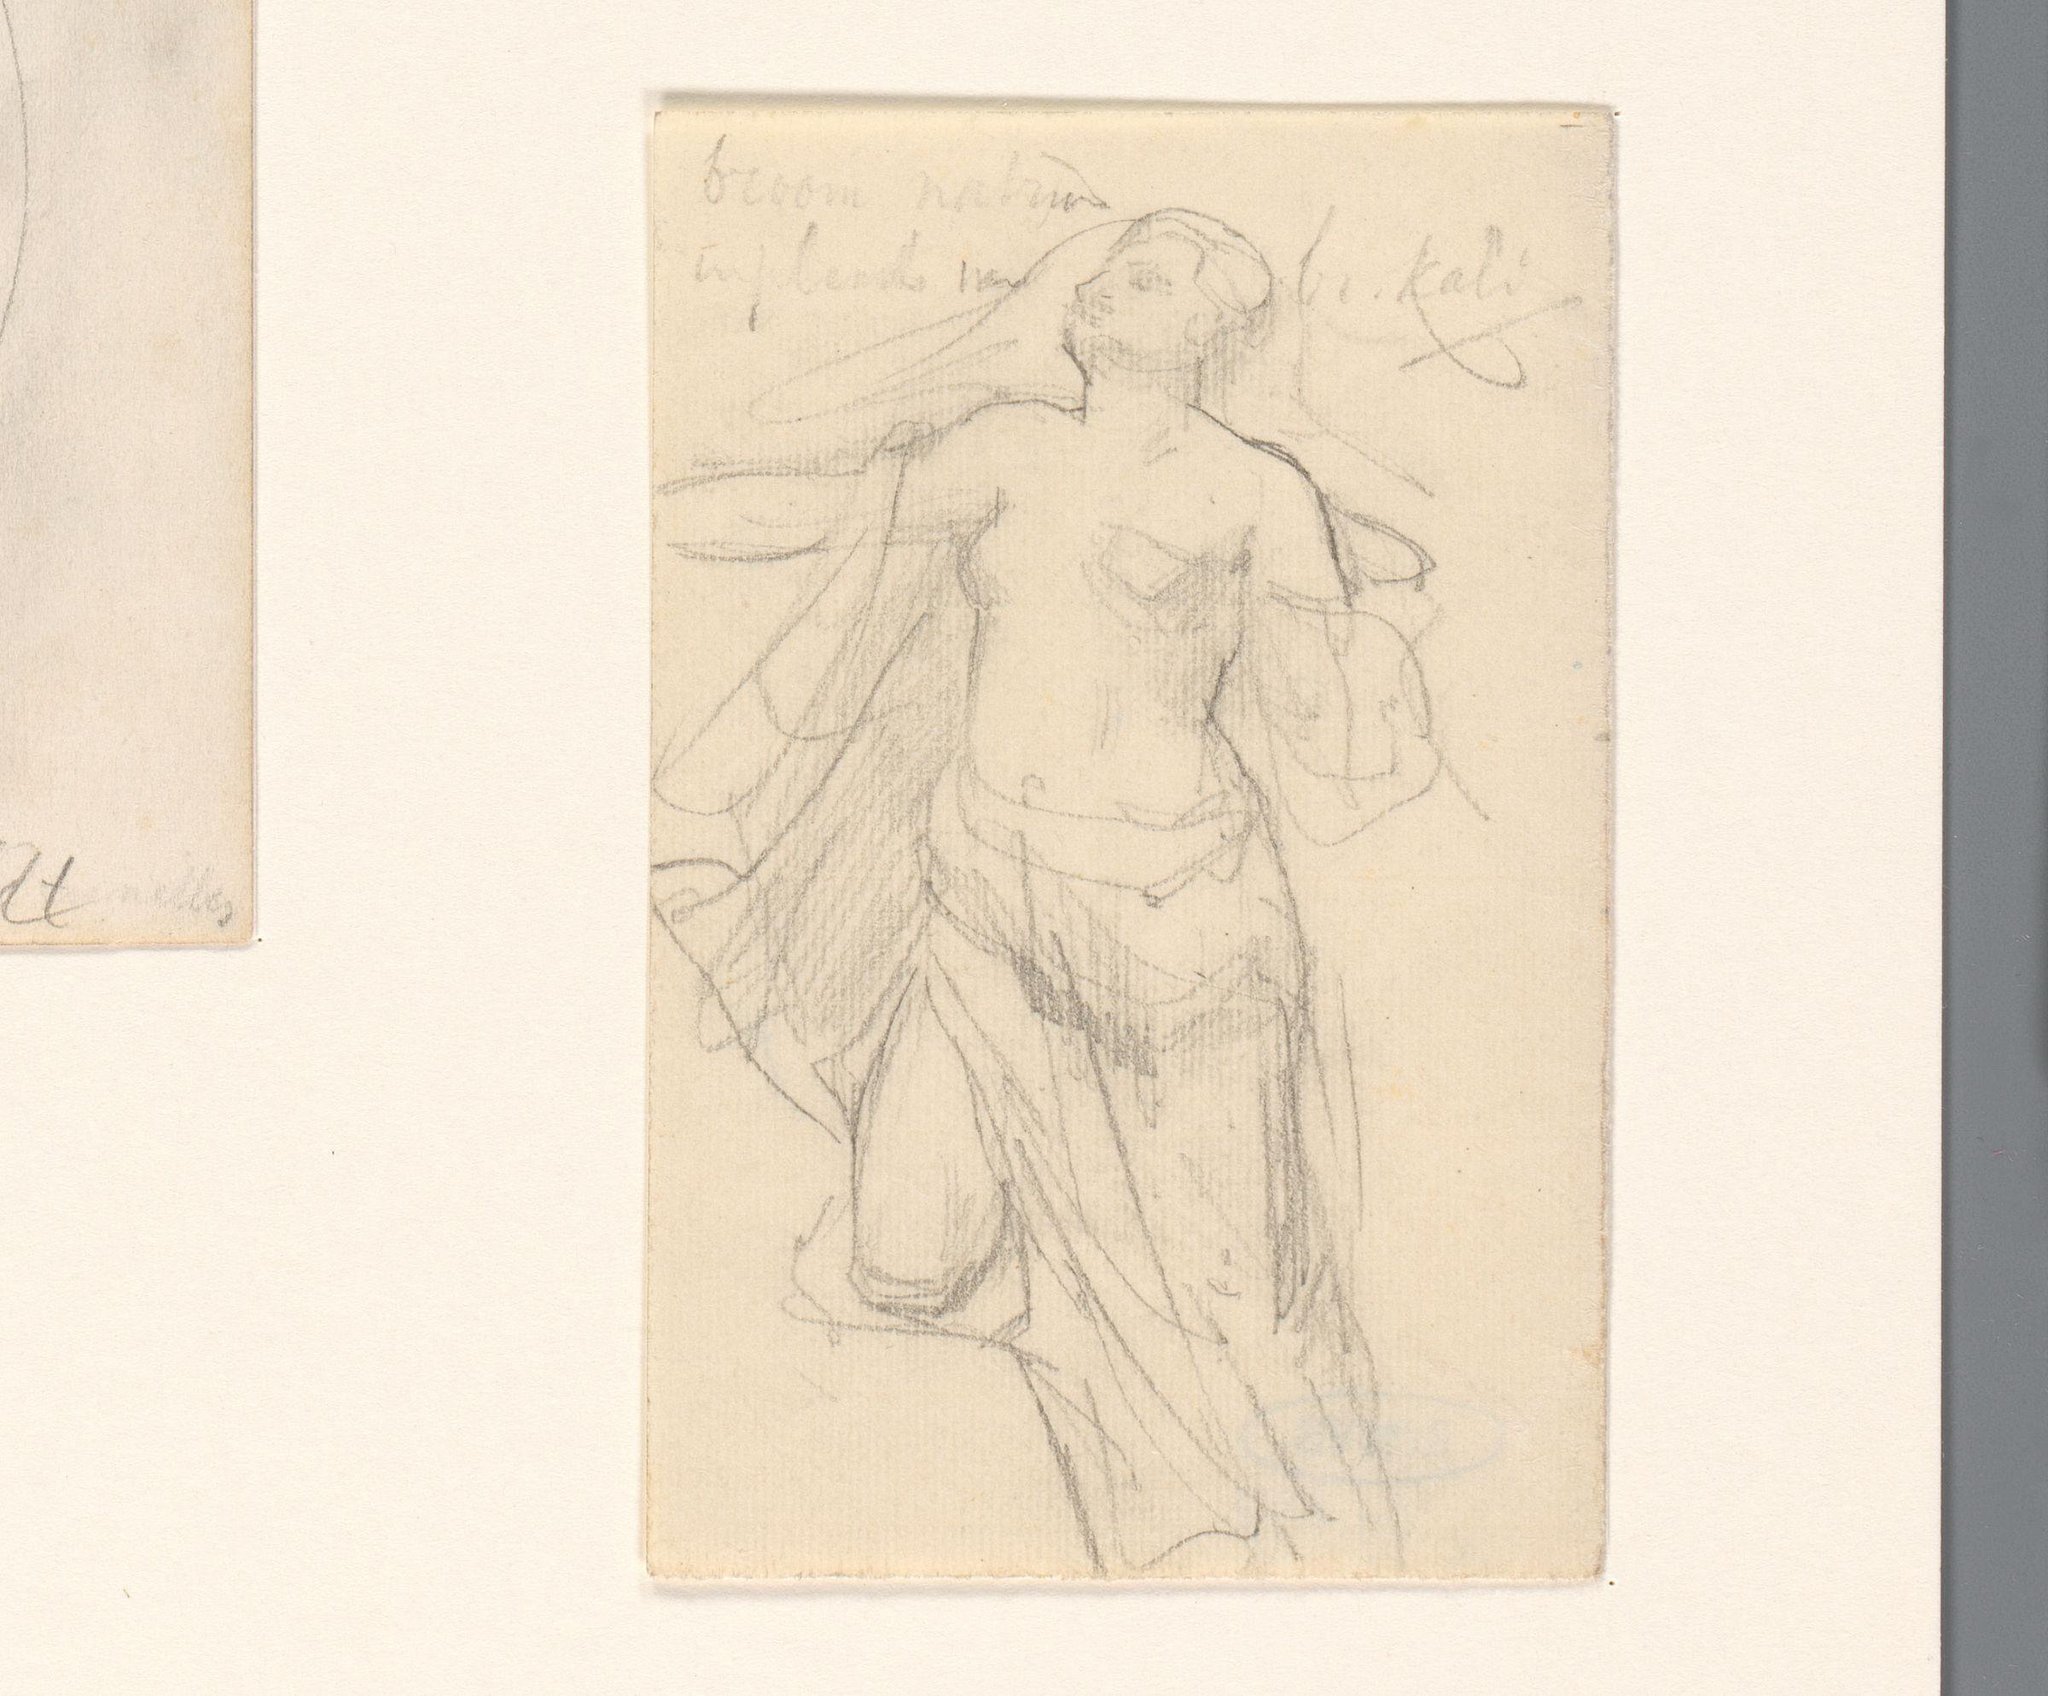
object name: drawing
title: Vrouwelijk naakt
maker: august allebé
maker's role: draughtsman, print maker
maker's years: 1838-1927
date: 1848-1927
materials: paper, pencil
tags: the (nude) human figure; 'corpo humano' (ripa), piece of sculpture, reproduction of a piece of sculpture